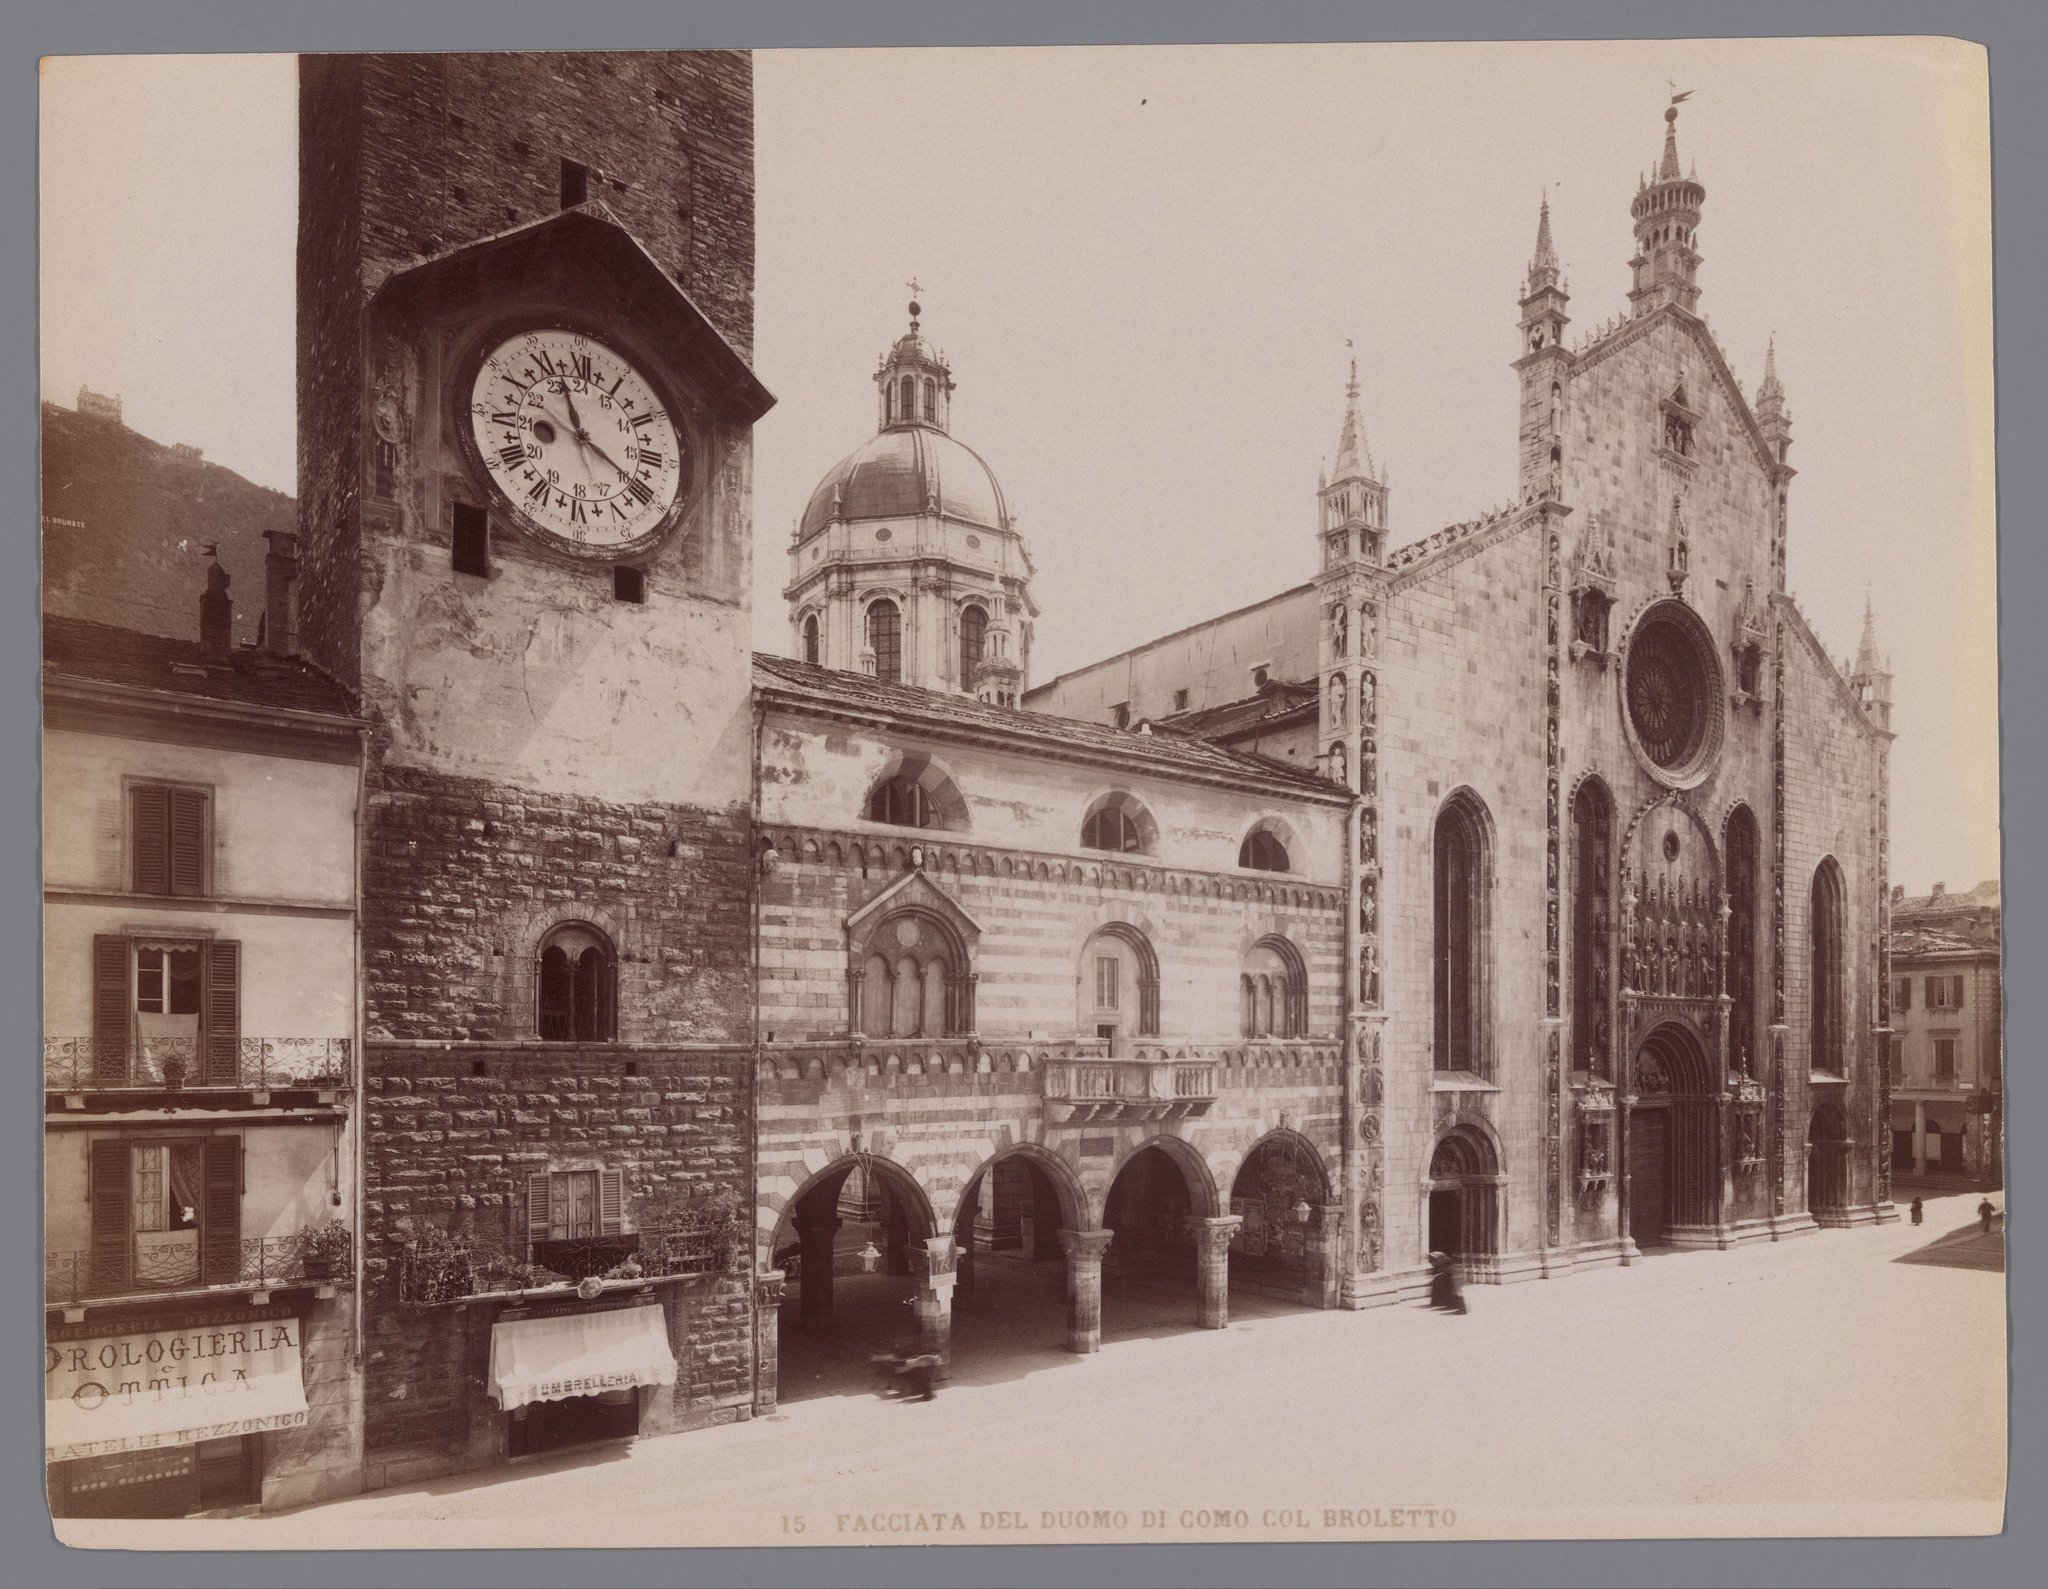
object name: photograph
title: Façade en koepel van de kathedraal van Como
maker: Anonymous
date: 1851-1900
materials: paper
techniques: albumen print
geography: como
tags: tower, clock tower ~ monumental adornment, parts of church exterior and annexes: dome, church (exterior)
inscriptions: number: ‘15’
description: Gezicht op de façade en koepel van de Duomo in Como, Italië. Foto genomen van schuin voor, met de kerkklok prominent in beeld. Verder een horlogemaker/opticien en en een parapluwinkel onder de toren en links in beeld.